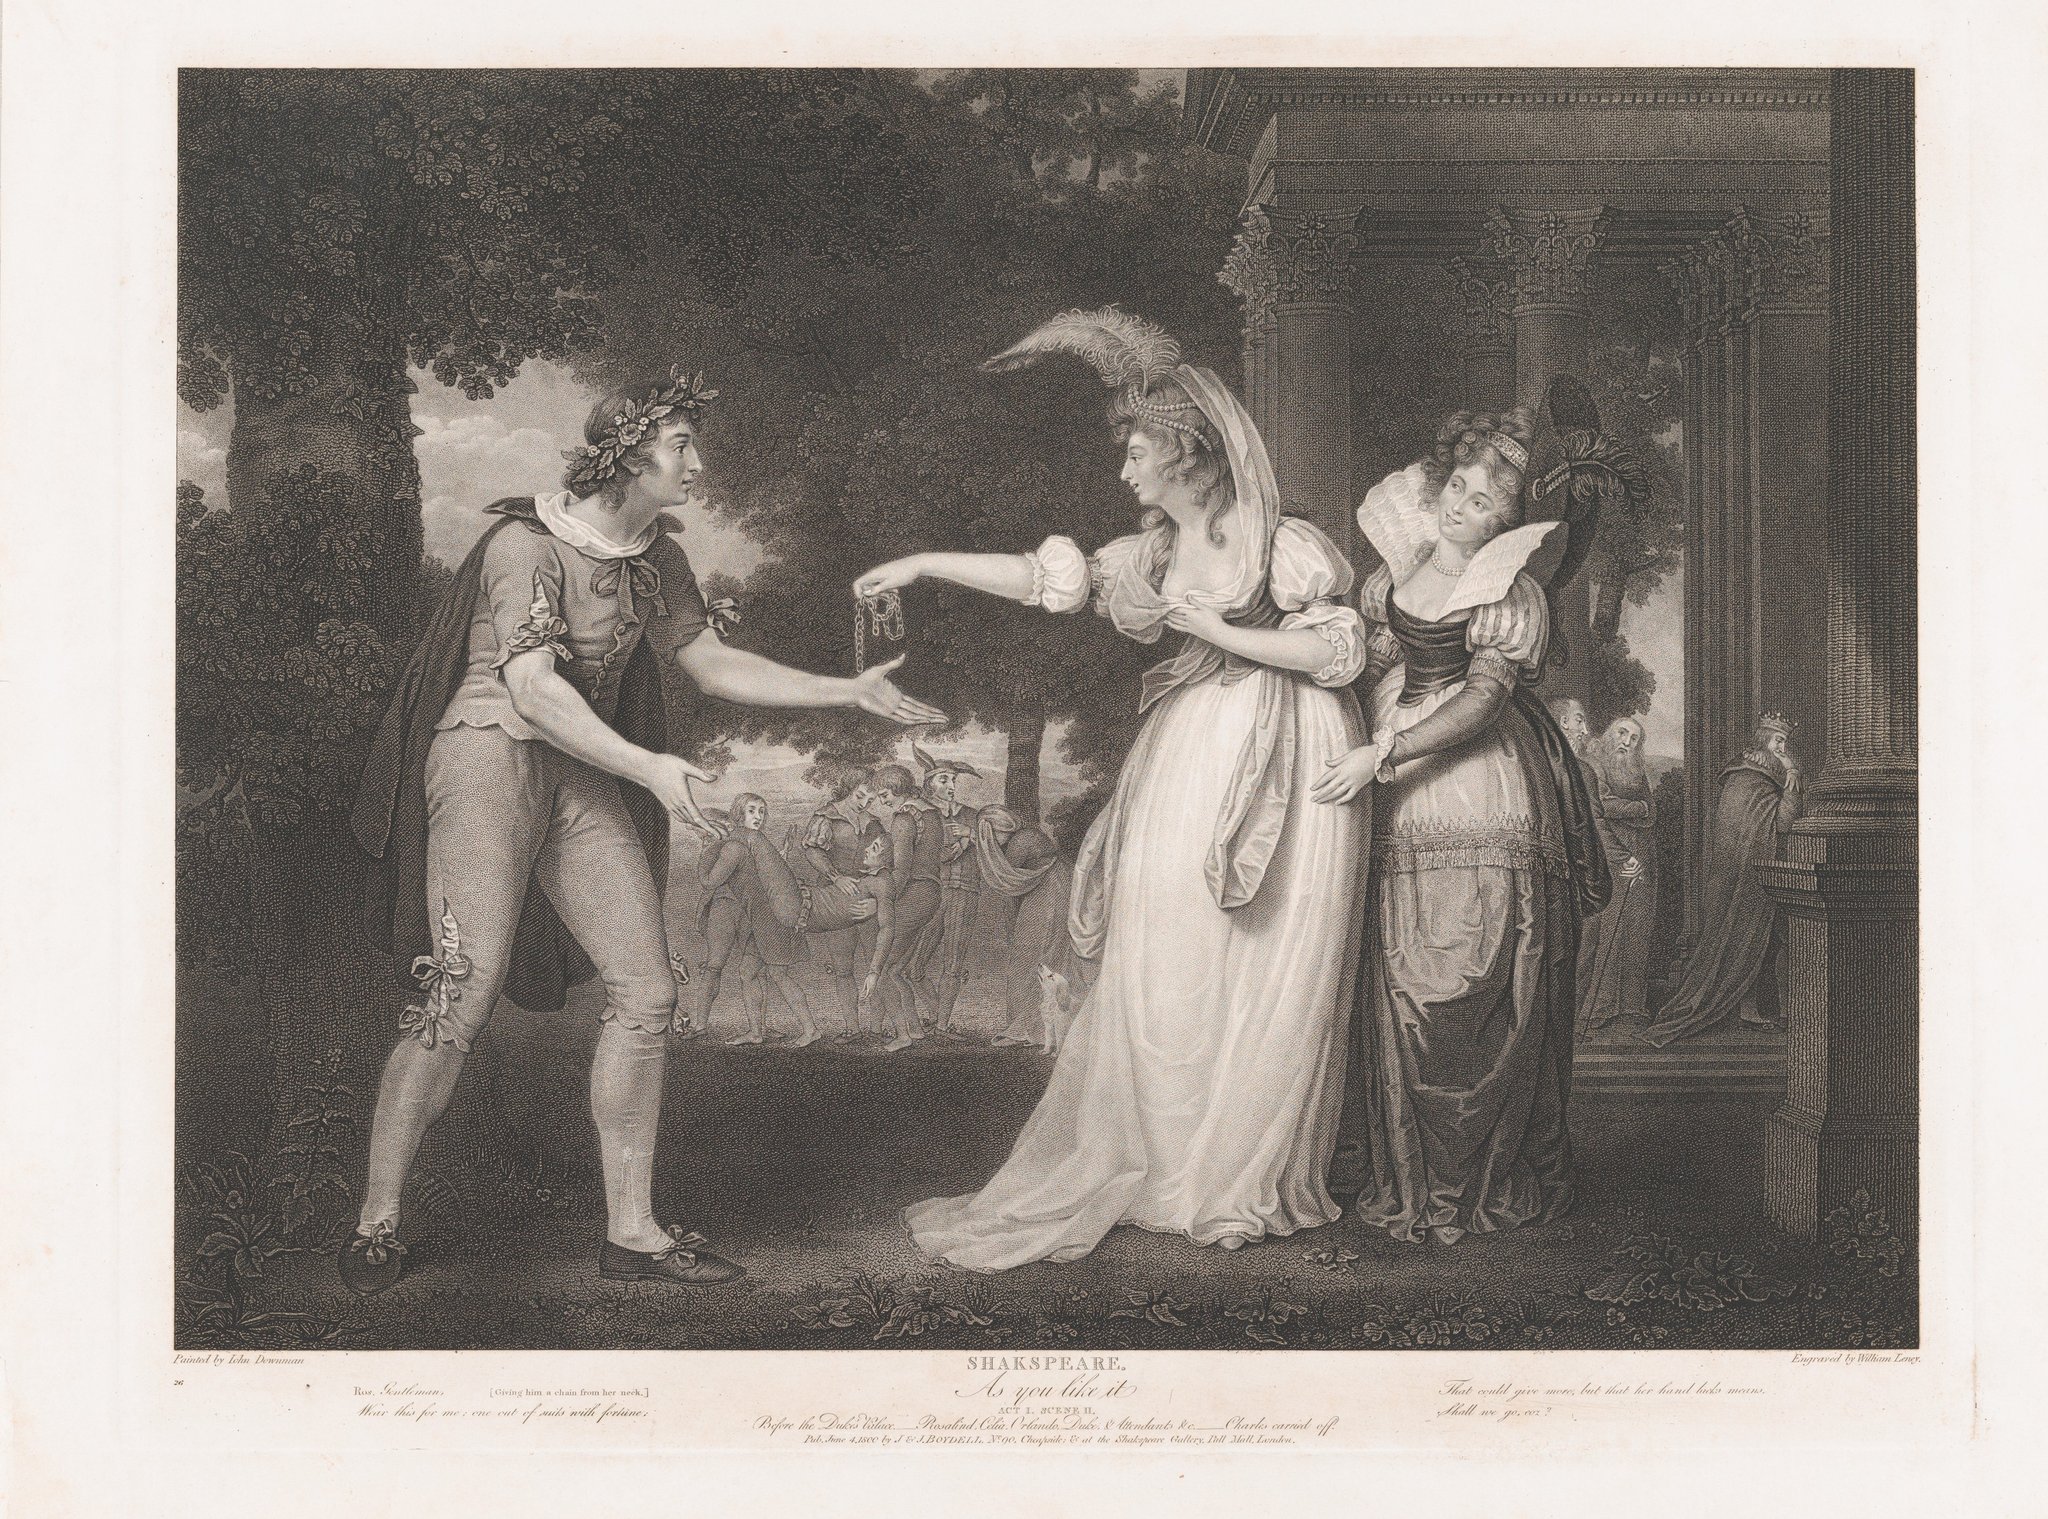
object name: print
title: Before the Duke's Palace–Rosalind, Celia, Orlando, the Duke & Attendants (Shakespeare, As You Like It, Act 1, Scene 2)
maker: william satchwell leney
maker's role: engraver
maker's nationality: american, born england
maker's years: 1769-1831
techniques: engraving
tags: shakespeare,men,women